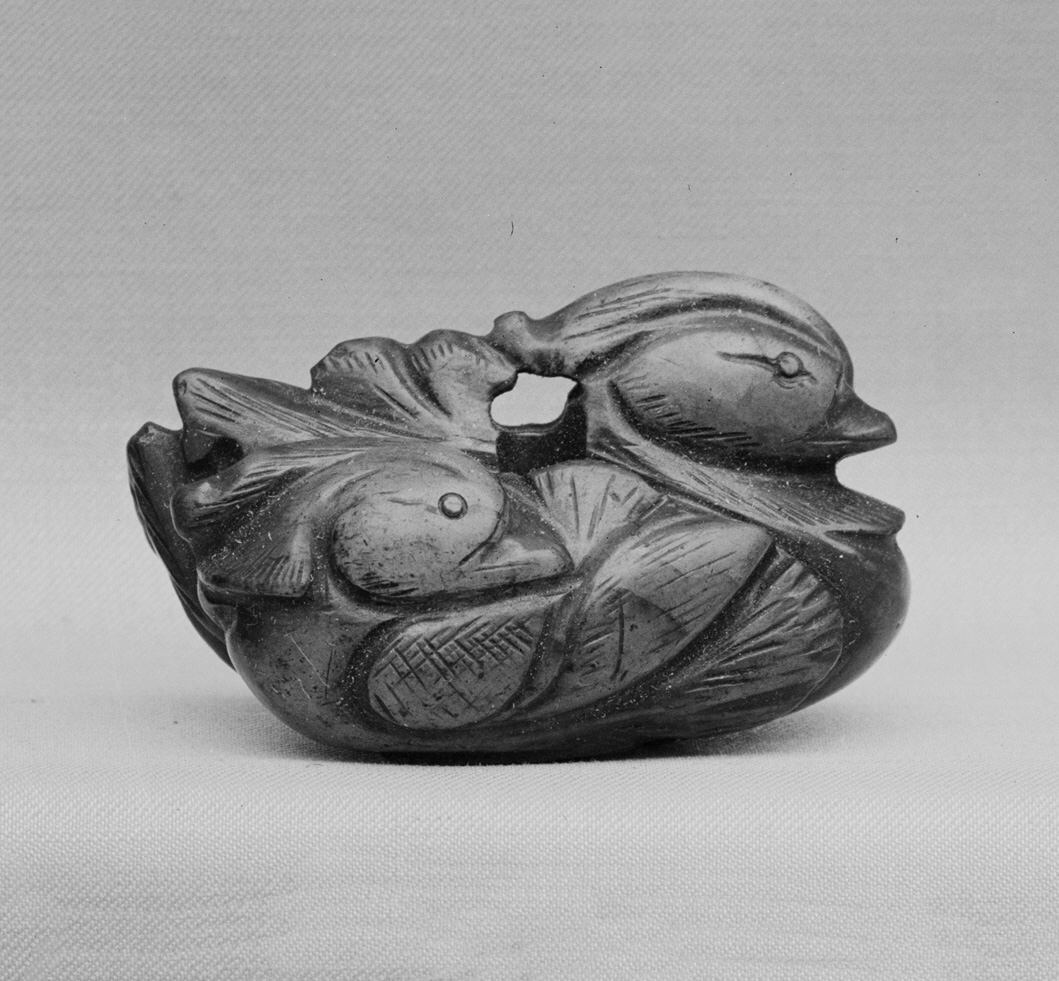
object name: ornament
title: Mandarin duck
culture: chinese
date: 1368-1644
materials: jade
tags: ducks